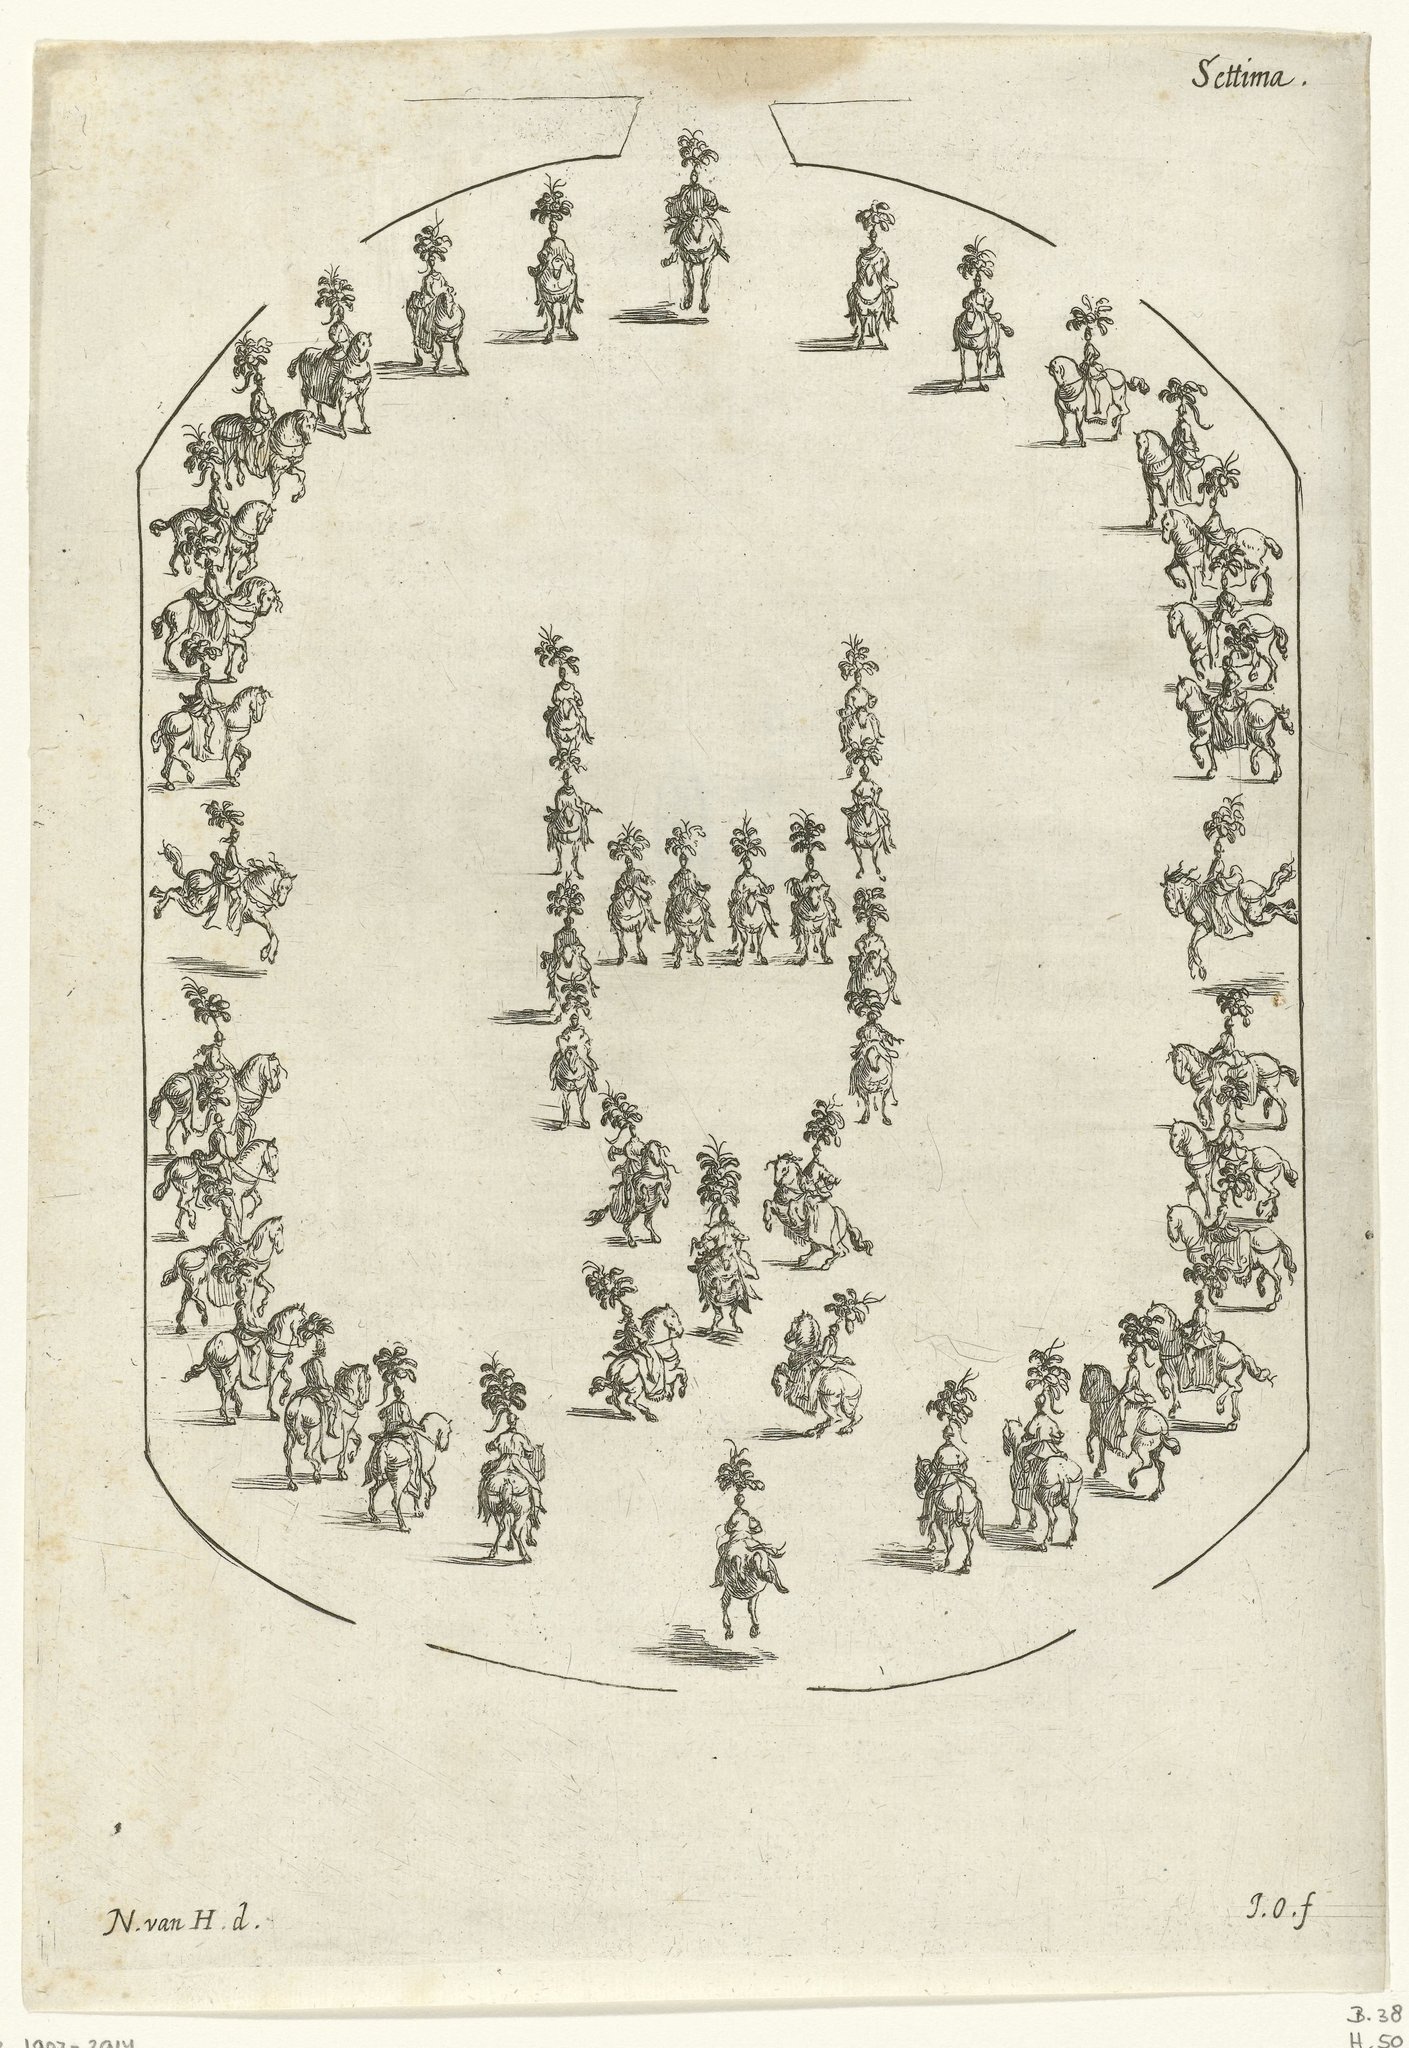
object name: print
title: Ruiterformaties (Settima)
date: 1667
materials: paper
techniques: etching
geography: vienna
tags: high-school riding, military honours (+ cavalry, horsemen)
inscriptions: collector's mark: Lugt 2228